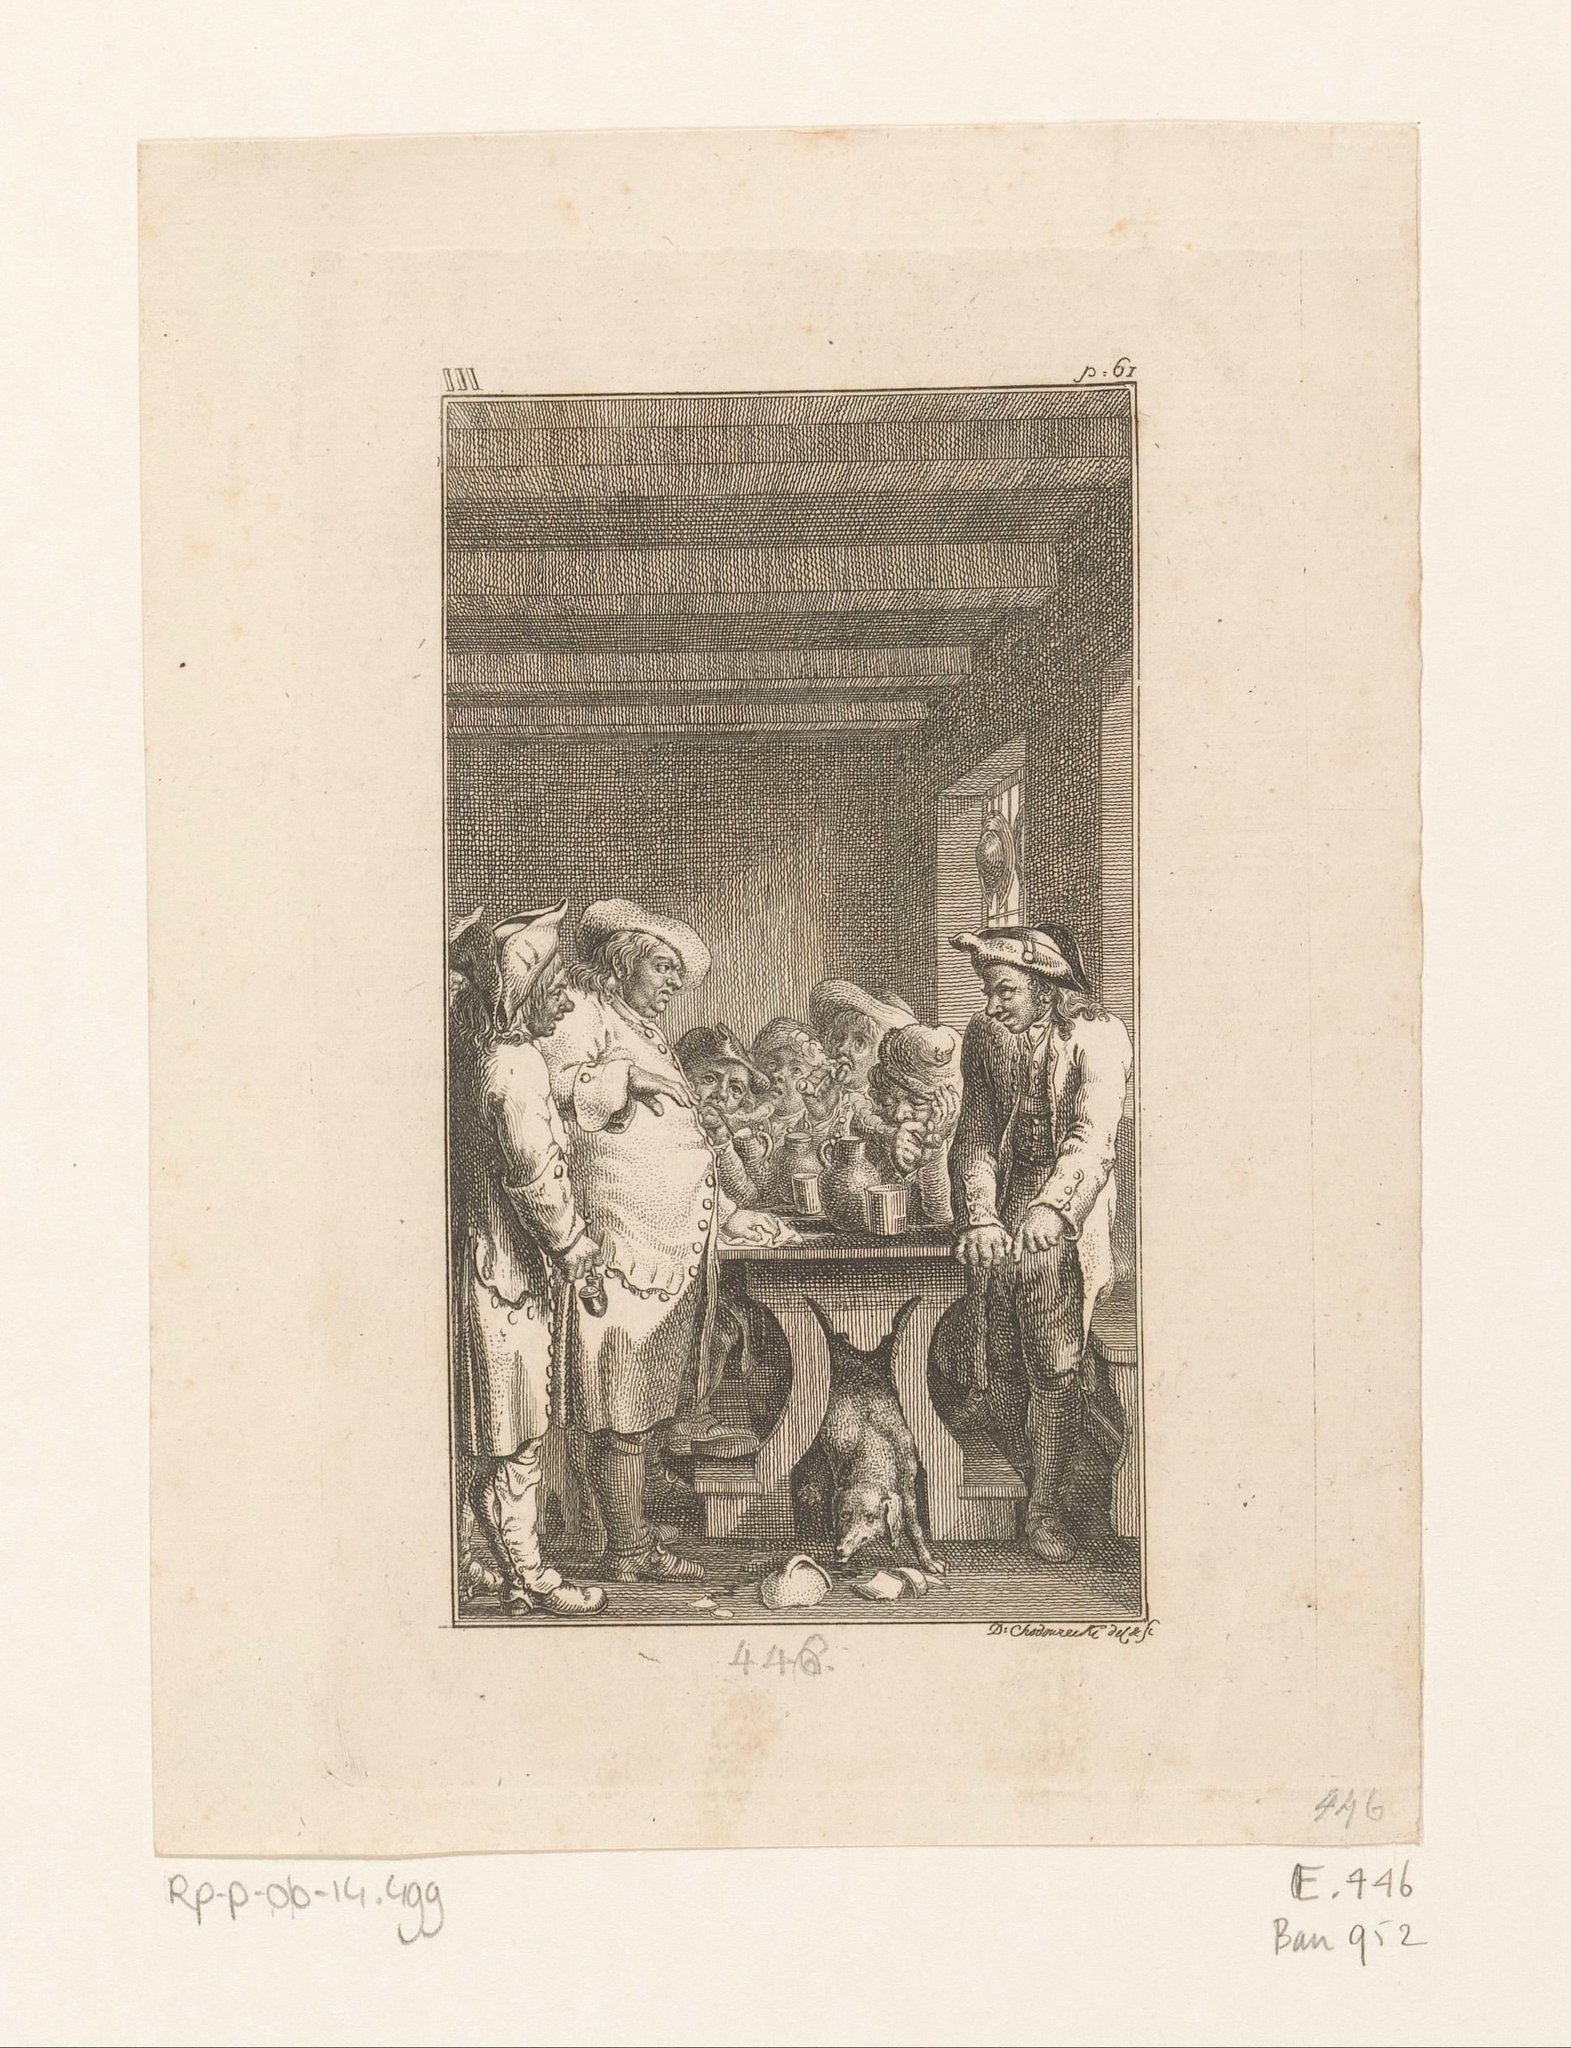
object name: book illustration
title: Himmels bedrog wordt ontdekt door de bouwlieden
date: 1782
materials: paper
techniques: etching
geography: berlin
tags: politician, building activities (+ labourers ~ crafts, industries, agriculture), alcoholic drinks, cheat, deceit; 'fraude', 'inganno' (ripa), dog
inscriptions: collector's mark: Lugt 2228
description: Prent gebruikt voor: Pestalozzi, Johann Heinrich. Léonard et Gertrude ou Les moeurs villageoises, telles qu'on les retrouve à la ville & à la cour. Berlijn: George Jacques Decker, 1783.